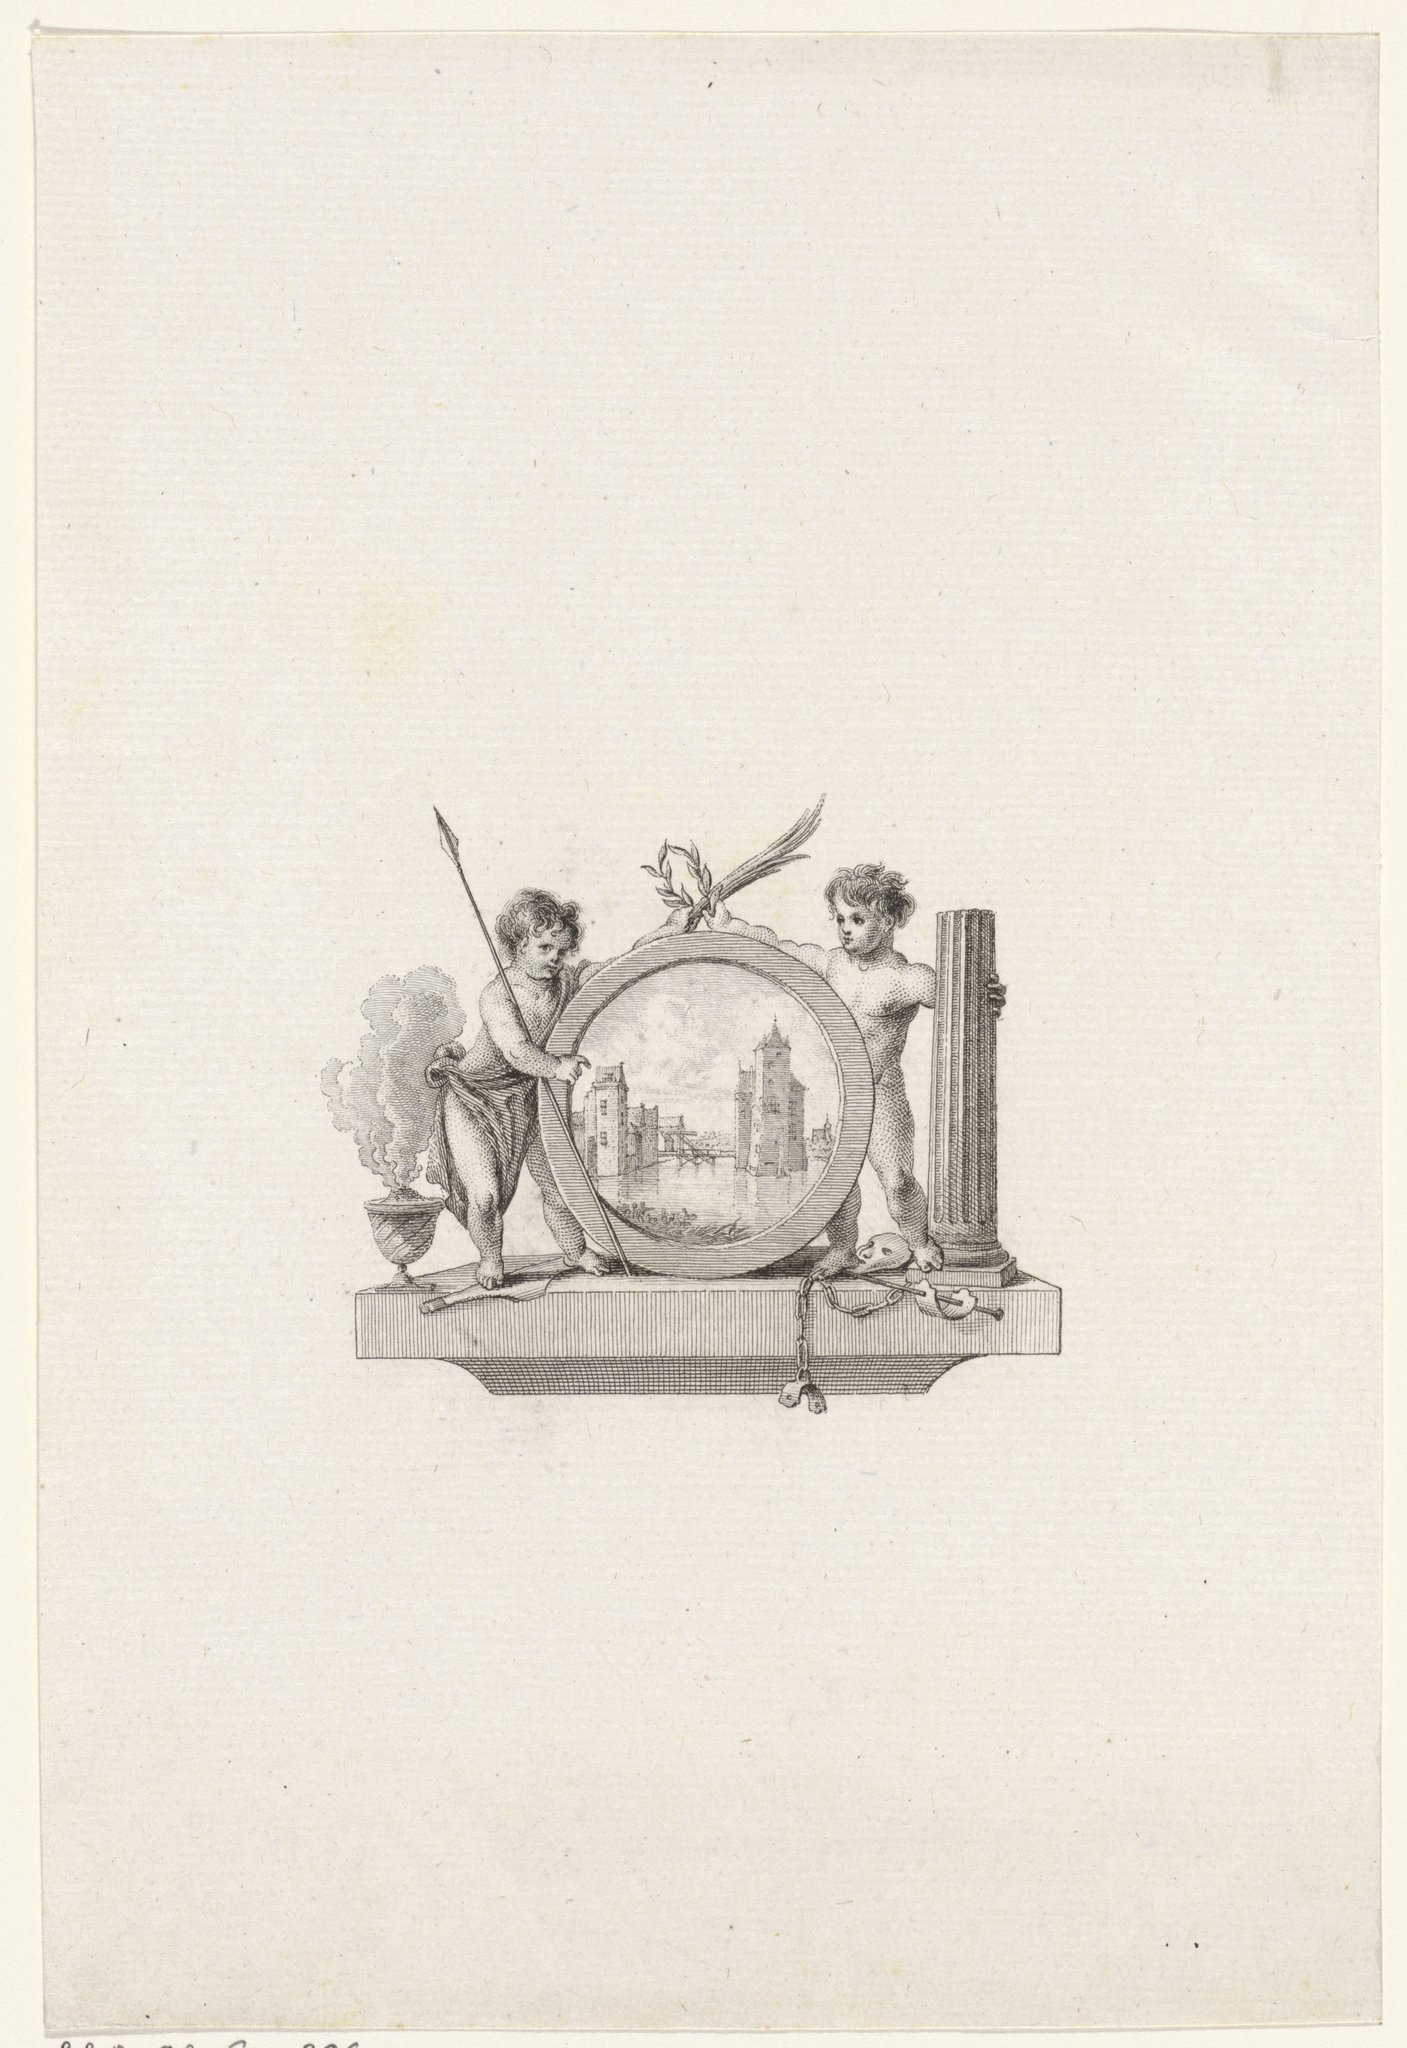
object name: print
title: Twee putti met een medaillon waarop een stadsgezicht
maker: reinier vinkeles (i)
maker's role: draughtsman, print maker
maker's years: 1741-1816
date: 1751-1816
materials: paper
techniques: engraving, etching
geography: amsterdam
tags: city-view in general; 'veduta', cupids: 'amores', 'amoretti', 'putti'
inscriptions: collector's mark: Lugt 2228